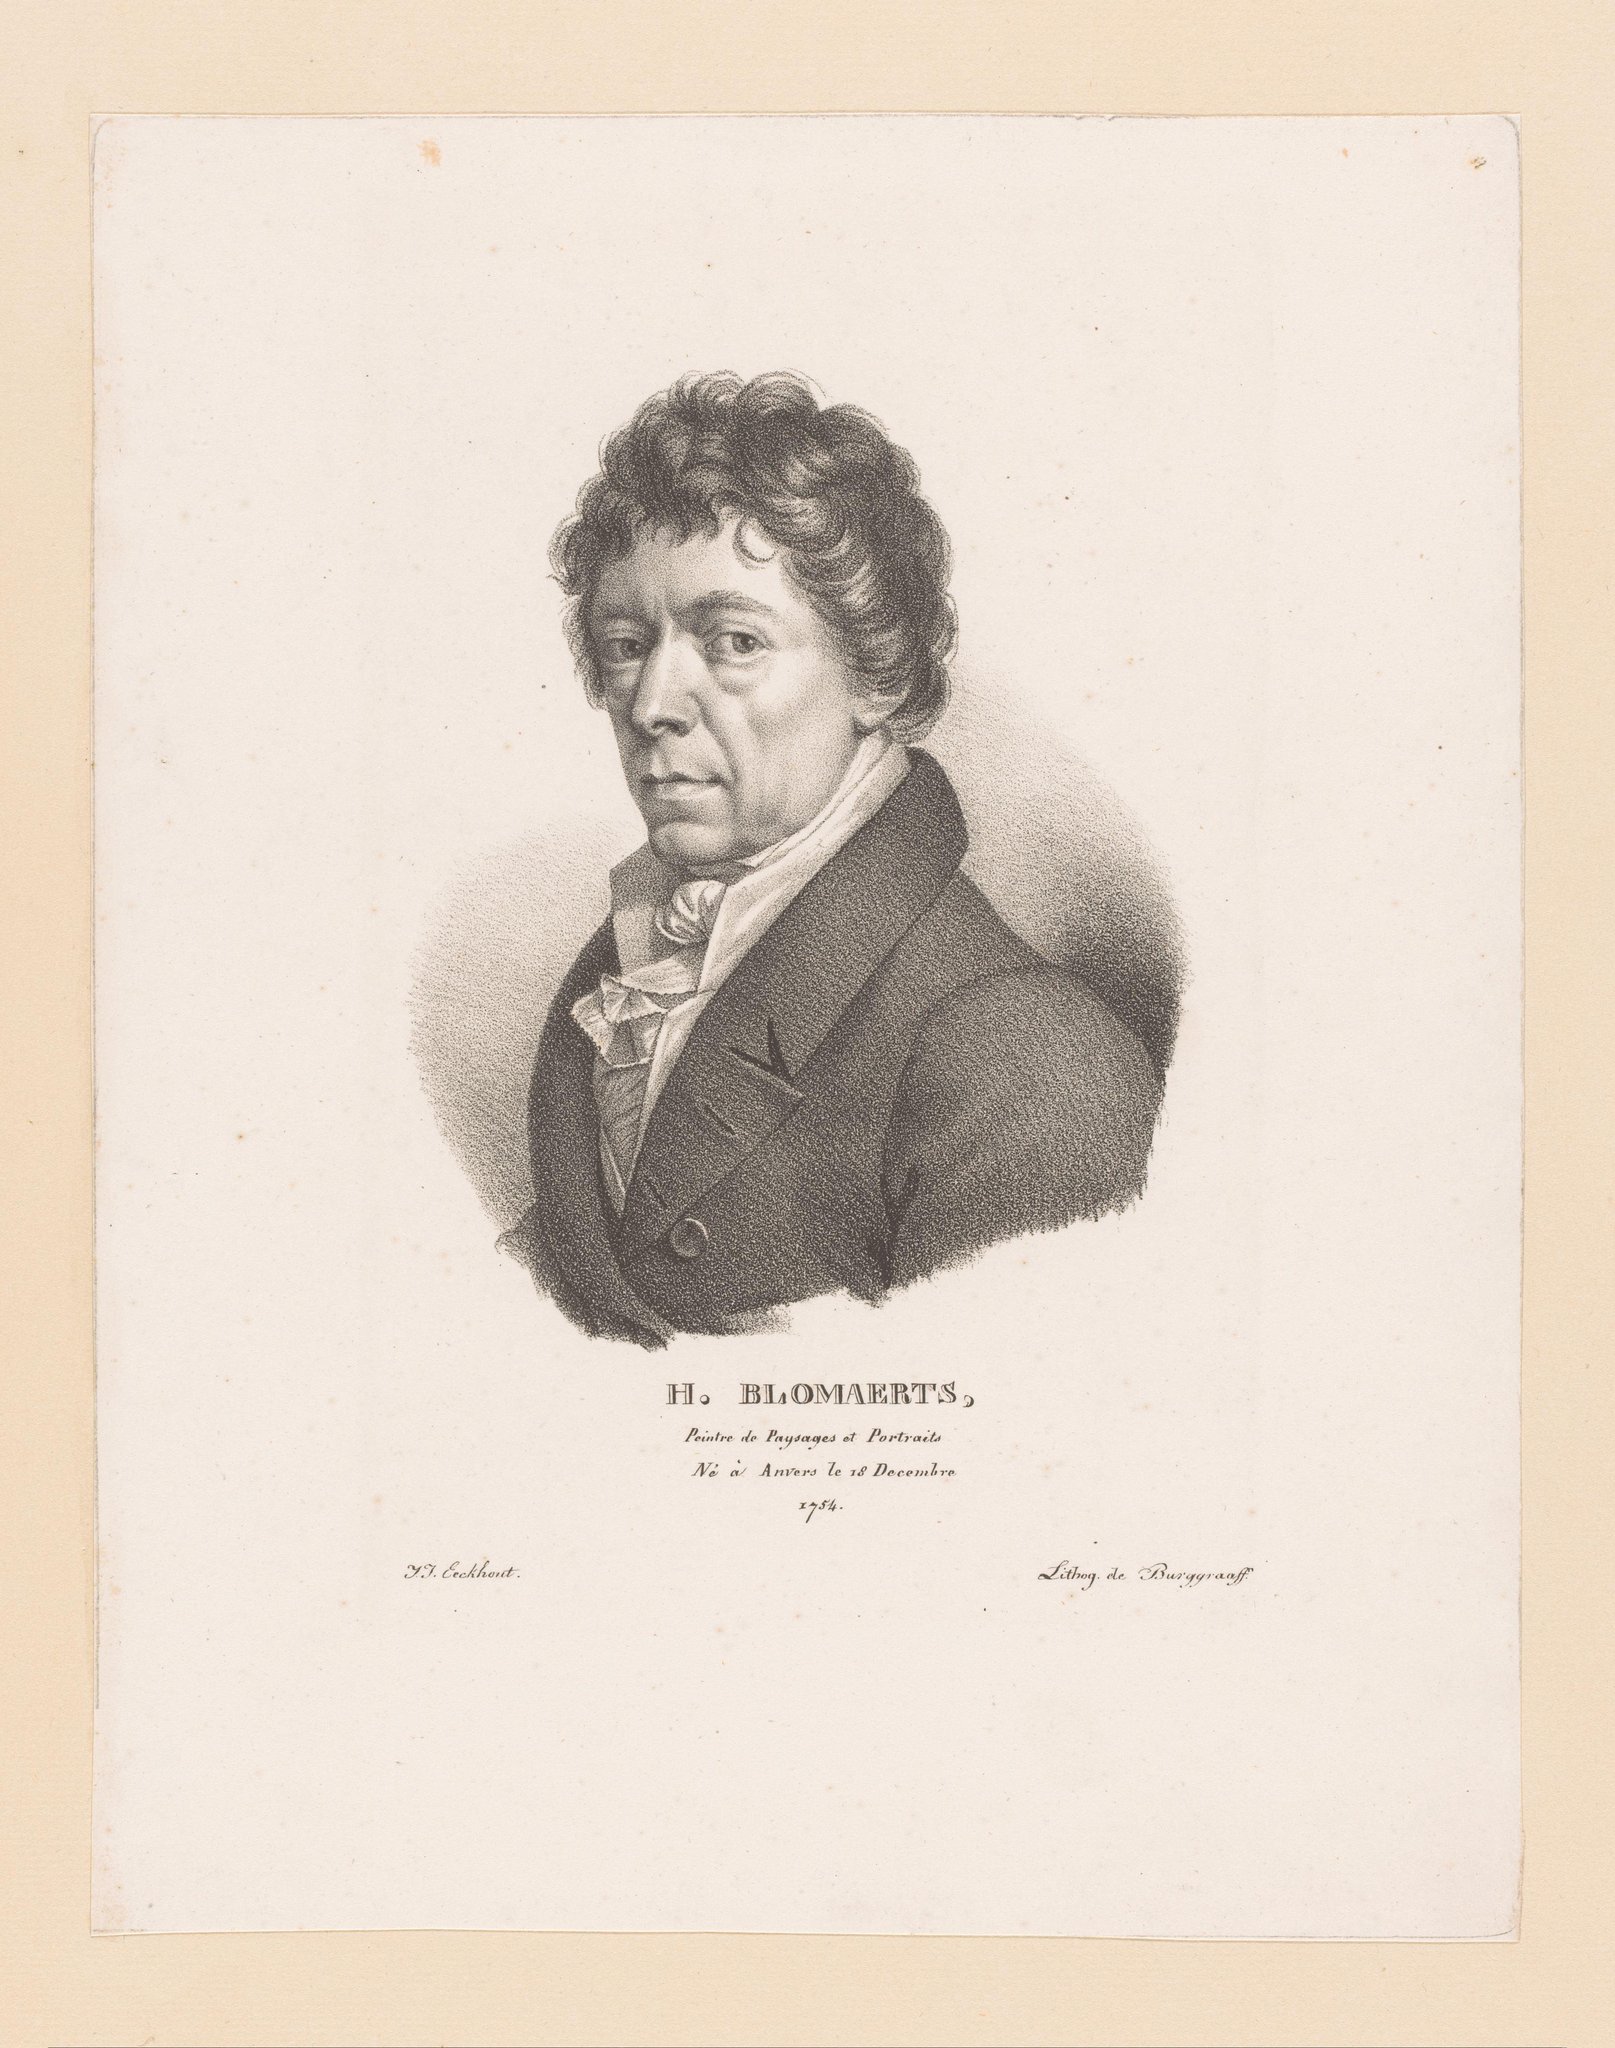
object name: print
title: Portretten van hedendaagse kunstenaars uit het Verenigd Koninkrijk der Nederlanden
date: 1822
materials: paper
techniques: lithograph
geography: brussels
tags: antwerp, brussels, historical persons, portrait, self-portrait of painter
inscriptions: collector's mark: Lugt 2228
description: Prent maakt deel uit van een serie van zestig prenten.